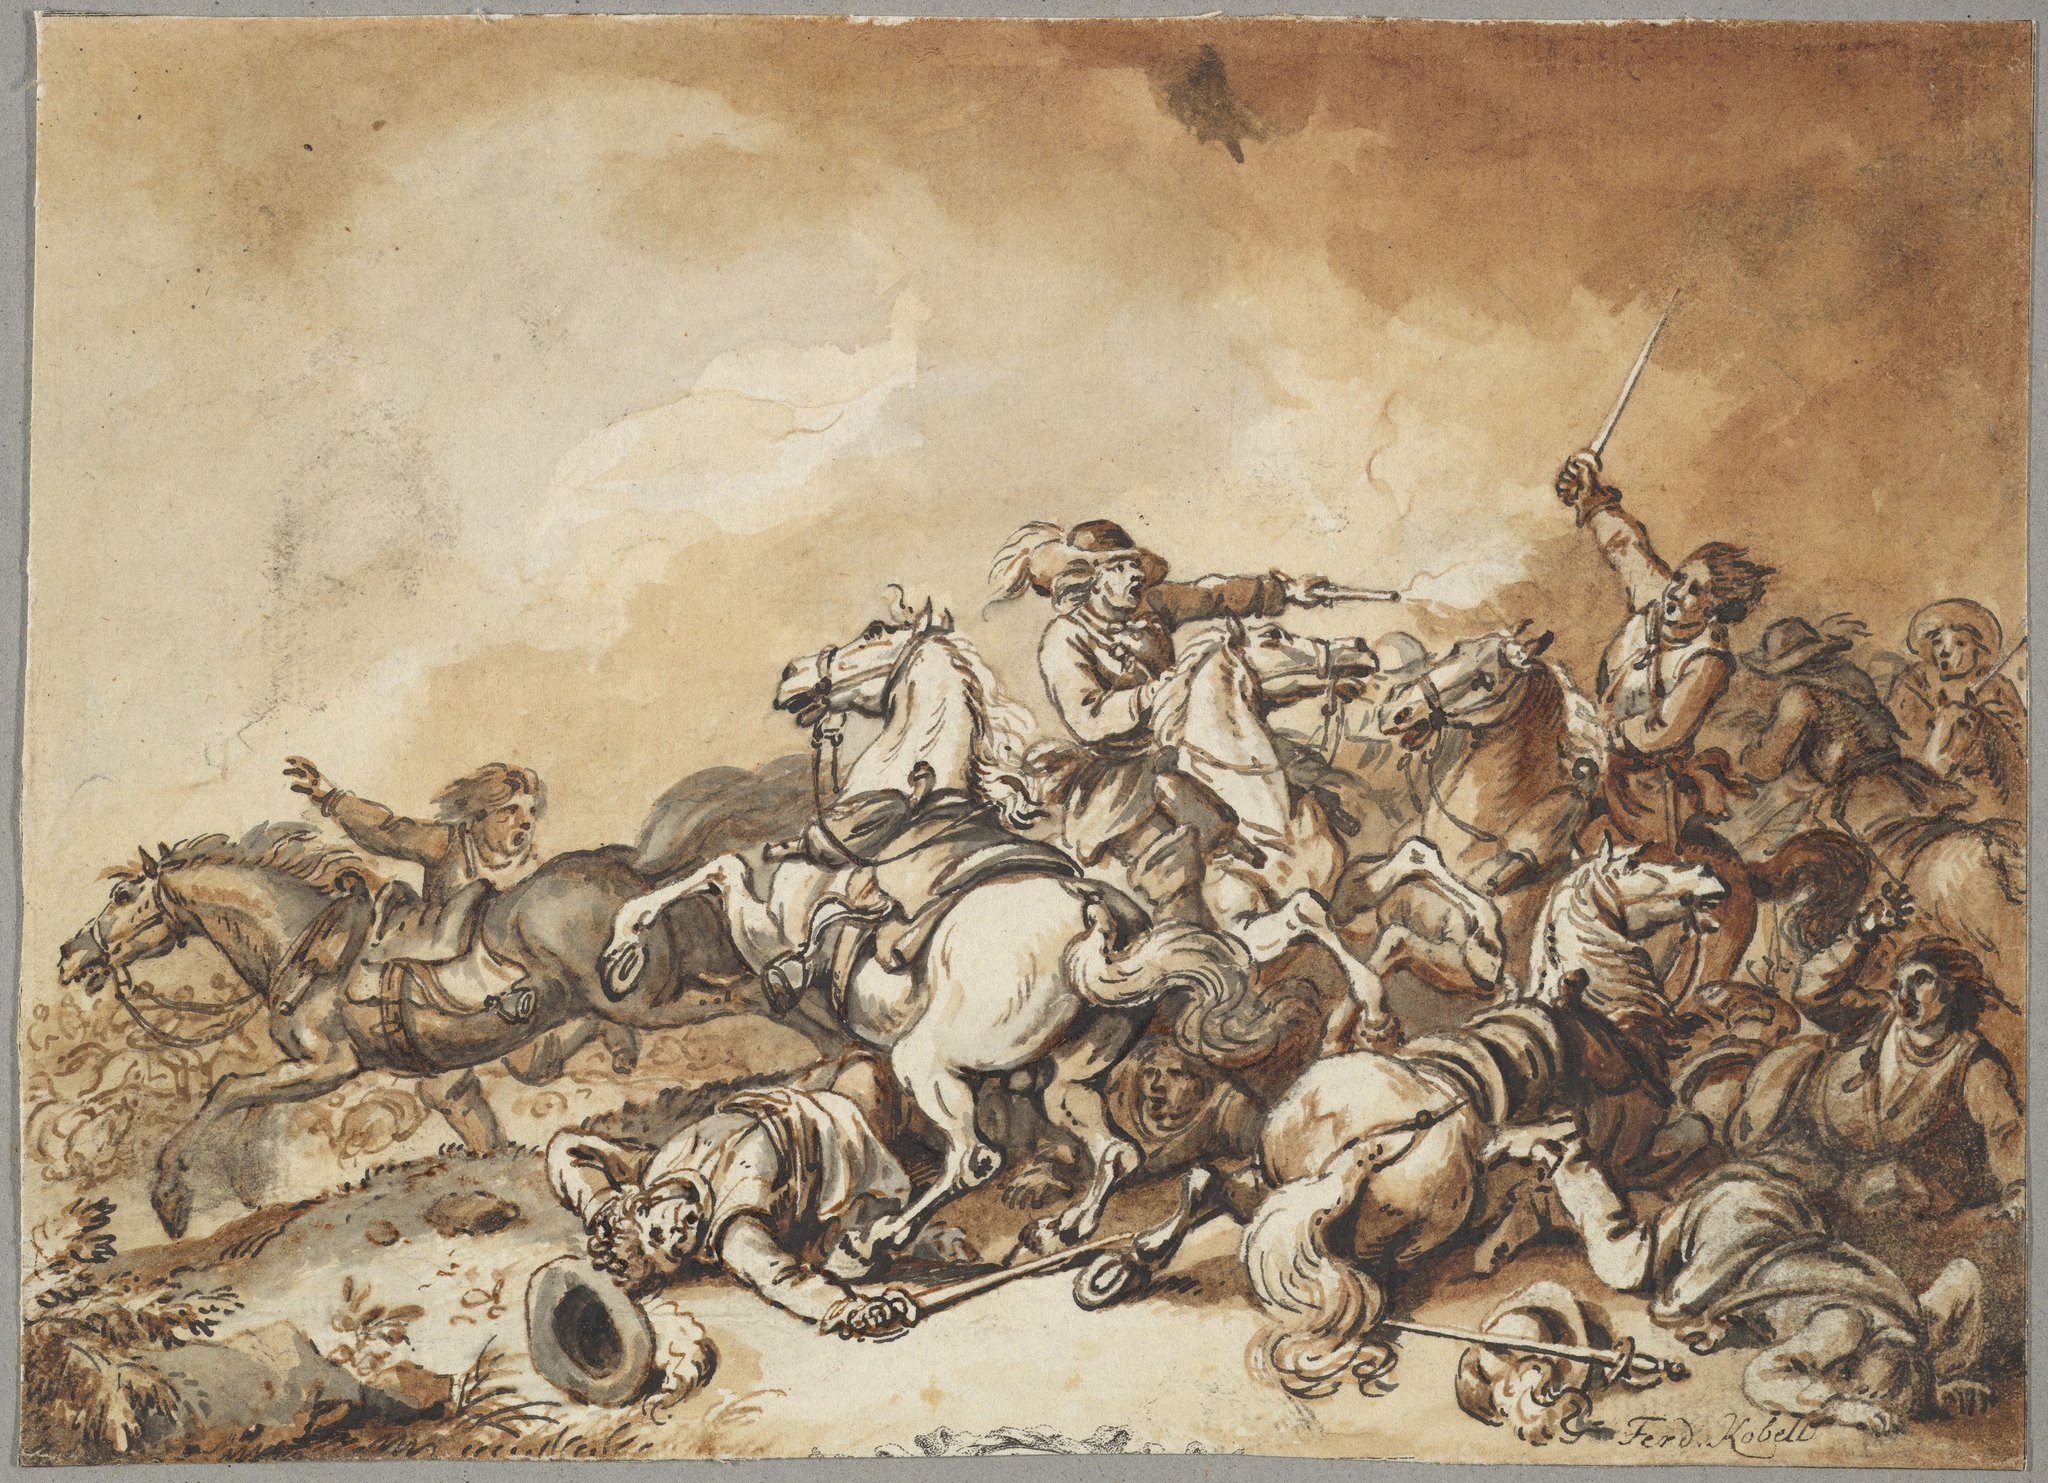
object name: drawing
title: A Battle Scene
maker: ferdinand kobell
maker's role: artist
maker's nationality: german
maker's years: 1740-1799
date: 1783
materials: chalk, ink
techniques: brush, engraving, pen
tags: battles,weapons,men,horses